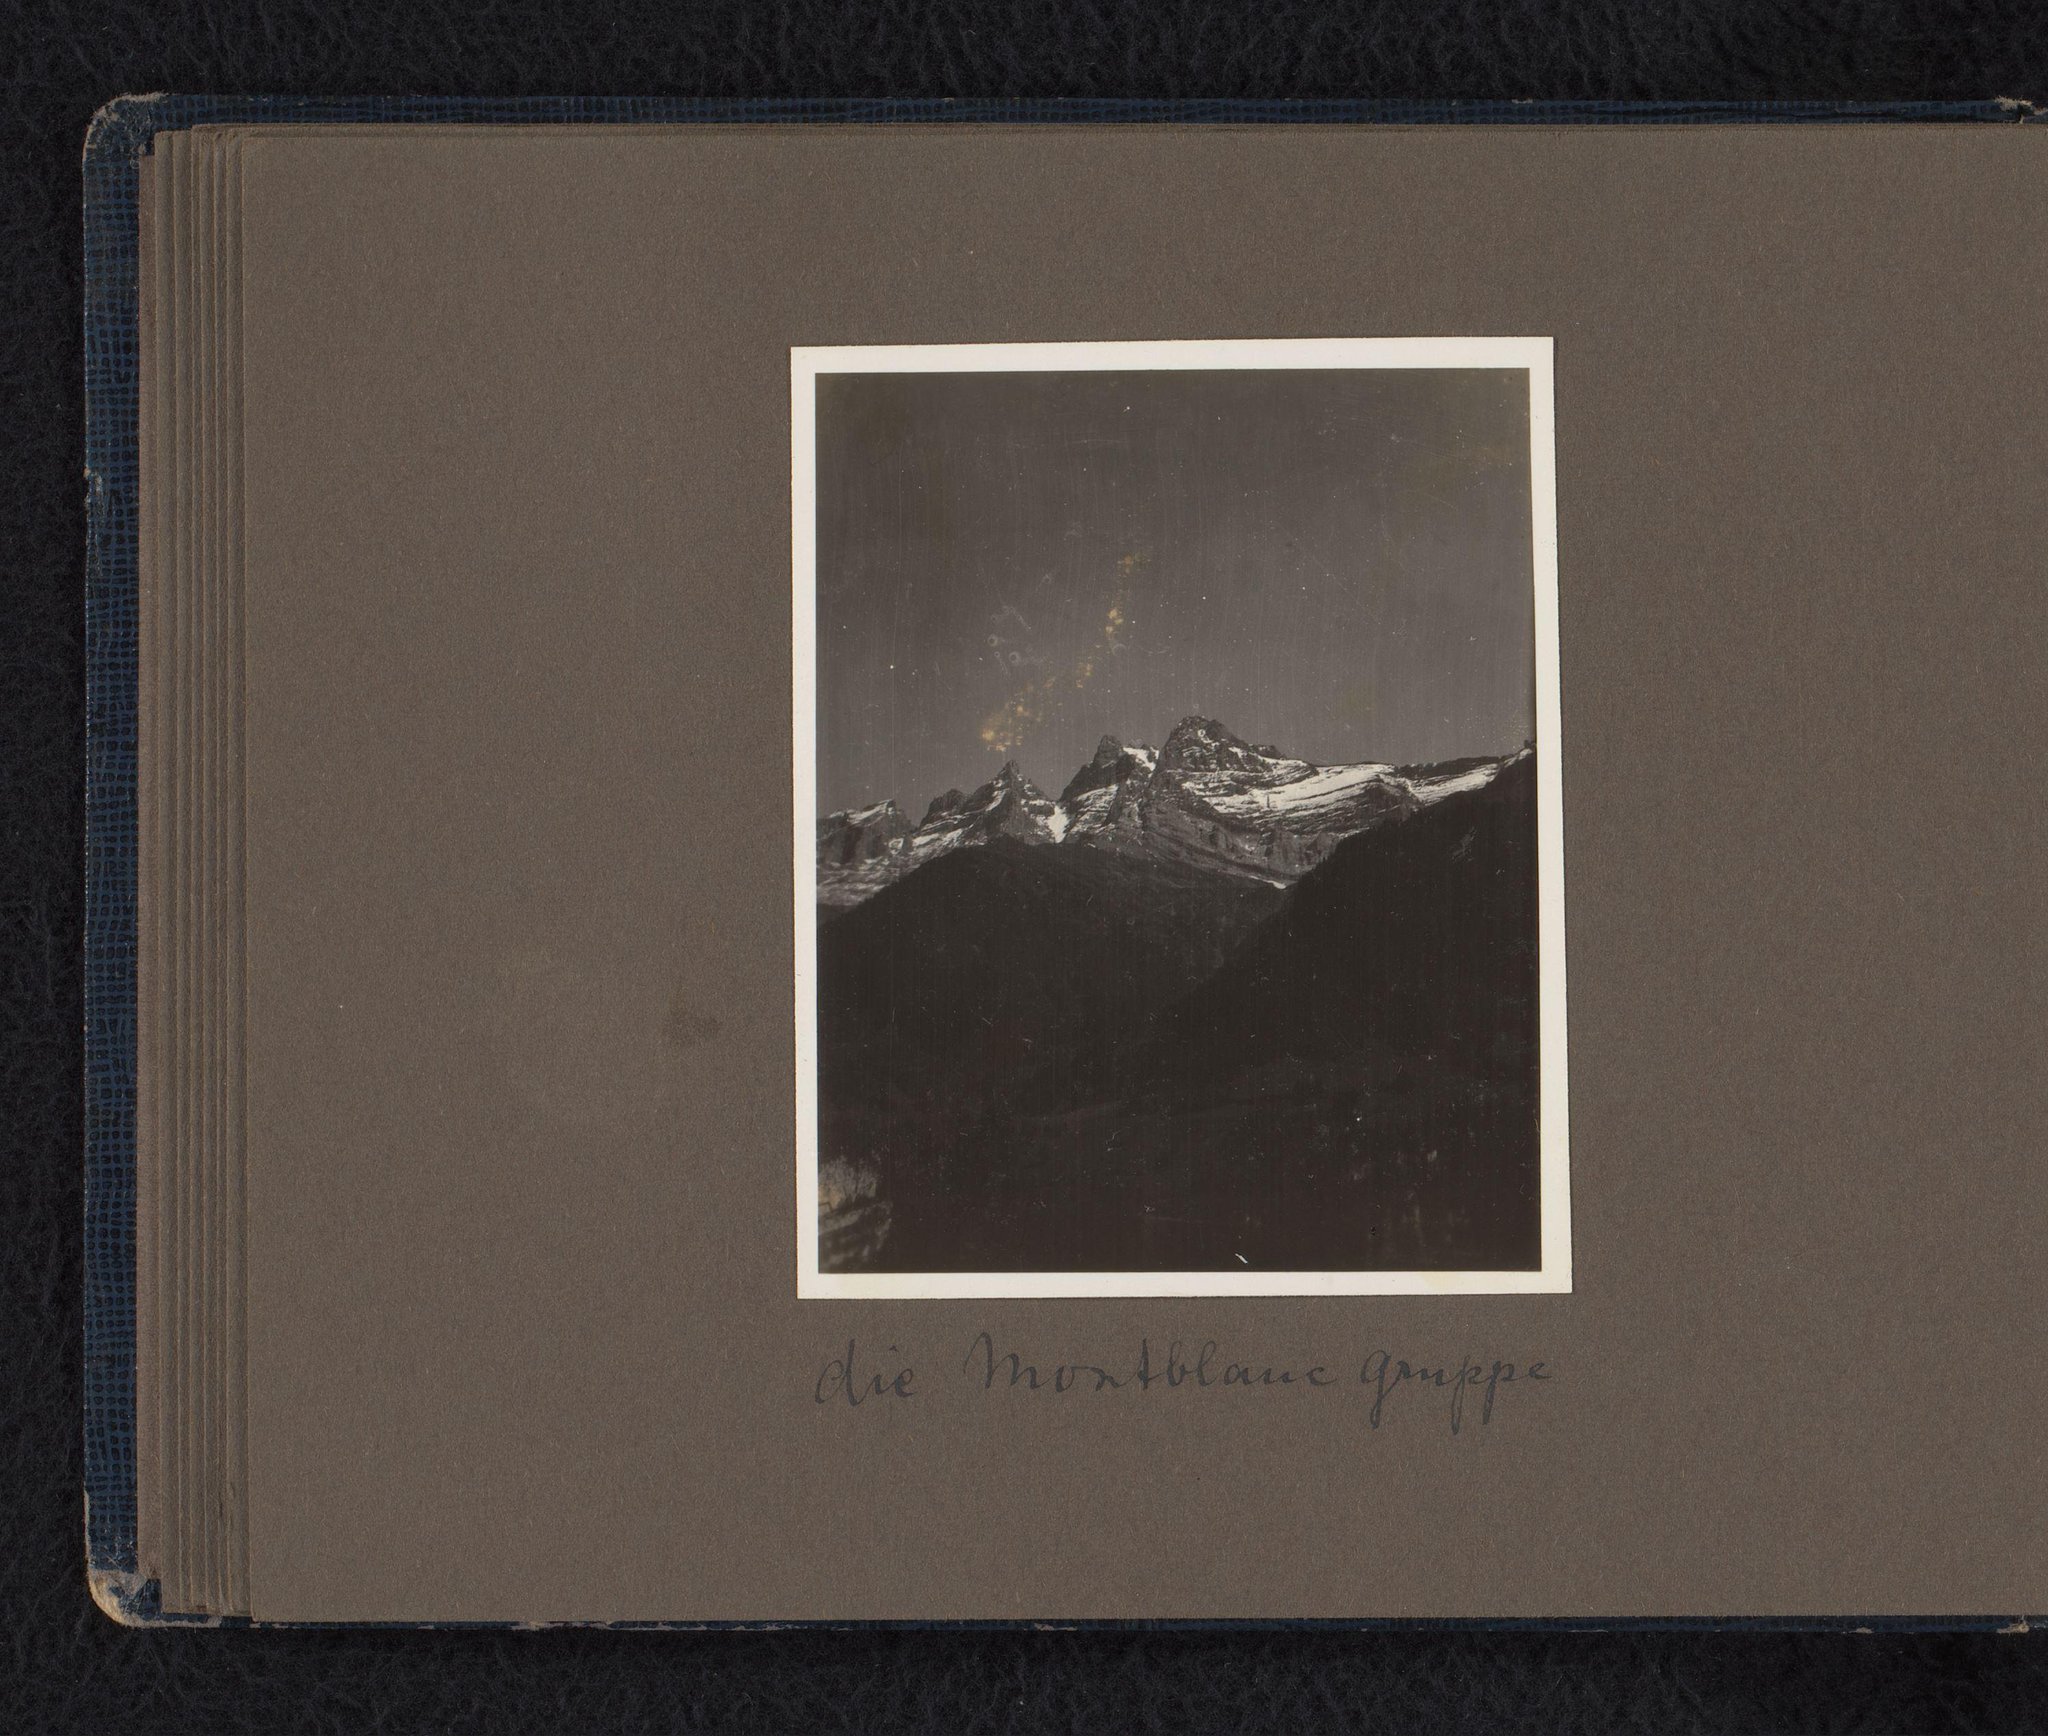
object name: photograph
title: De Mont Blanc, tijdens een vakantie van Eugen Wachenheimer en zijn echtgenote Else Wachenheimer-Moos door Zwitserland, augustus 1927, Mont Blanc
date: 1908-1927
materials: paper, photographic support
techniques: gelatin silver print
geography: switzerland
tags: mountain-range, snow peaks, switzerland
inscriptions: inscription: ‘die Mont Blanc gruppe’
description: Albumblad bevat een foto van landschap zonder personen. Uit album half formaat, blauw kunstlederen omslag met koordbinding.